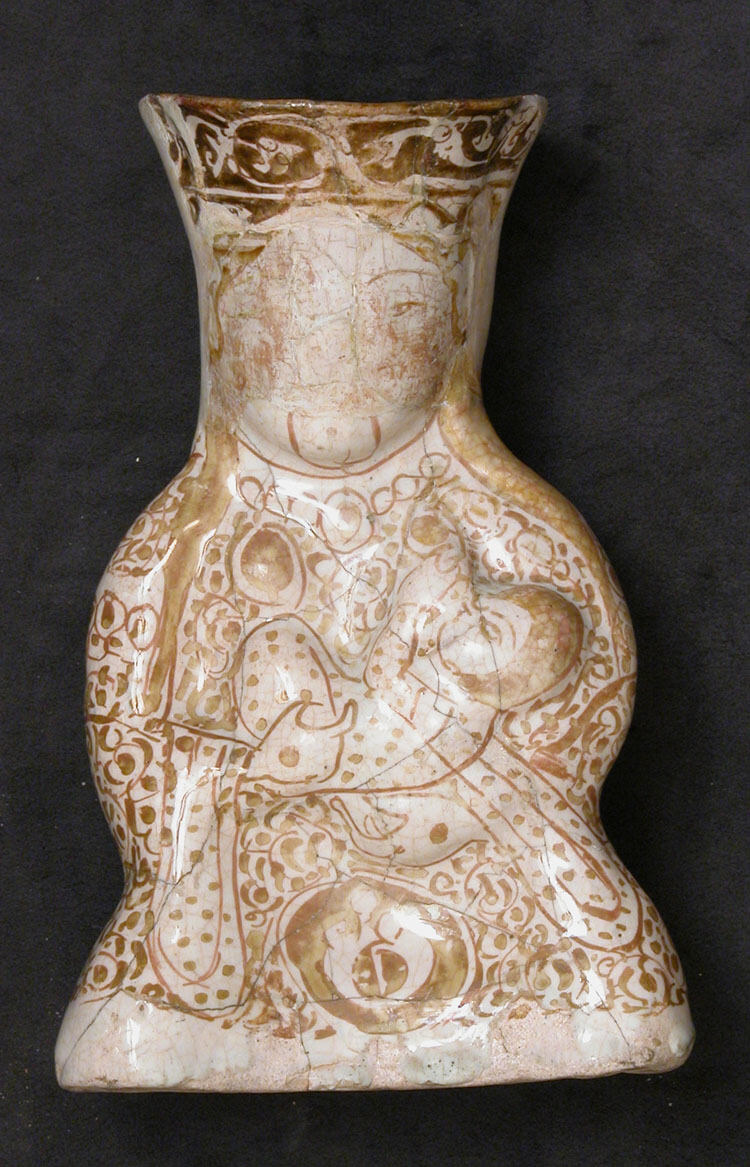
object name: figural vessel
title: Hollow Vessel in the Shape of a Woman Holding a Child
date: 1101-1300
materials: glaze, stonepaste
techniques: luster painting, molding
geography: iran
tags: infants,women,nursing